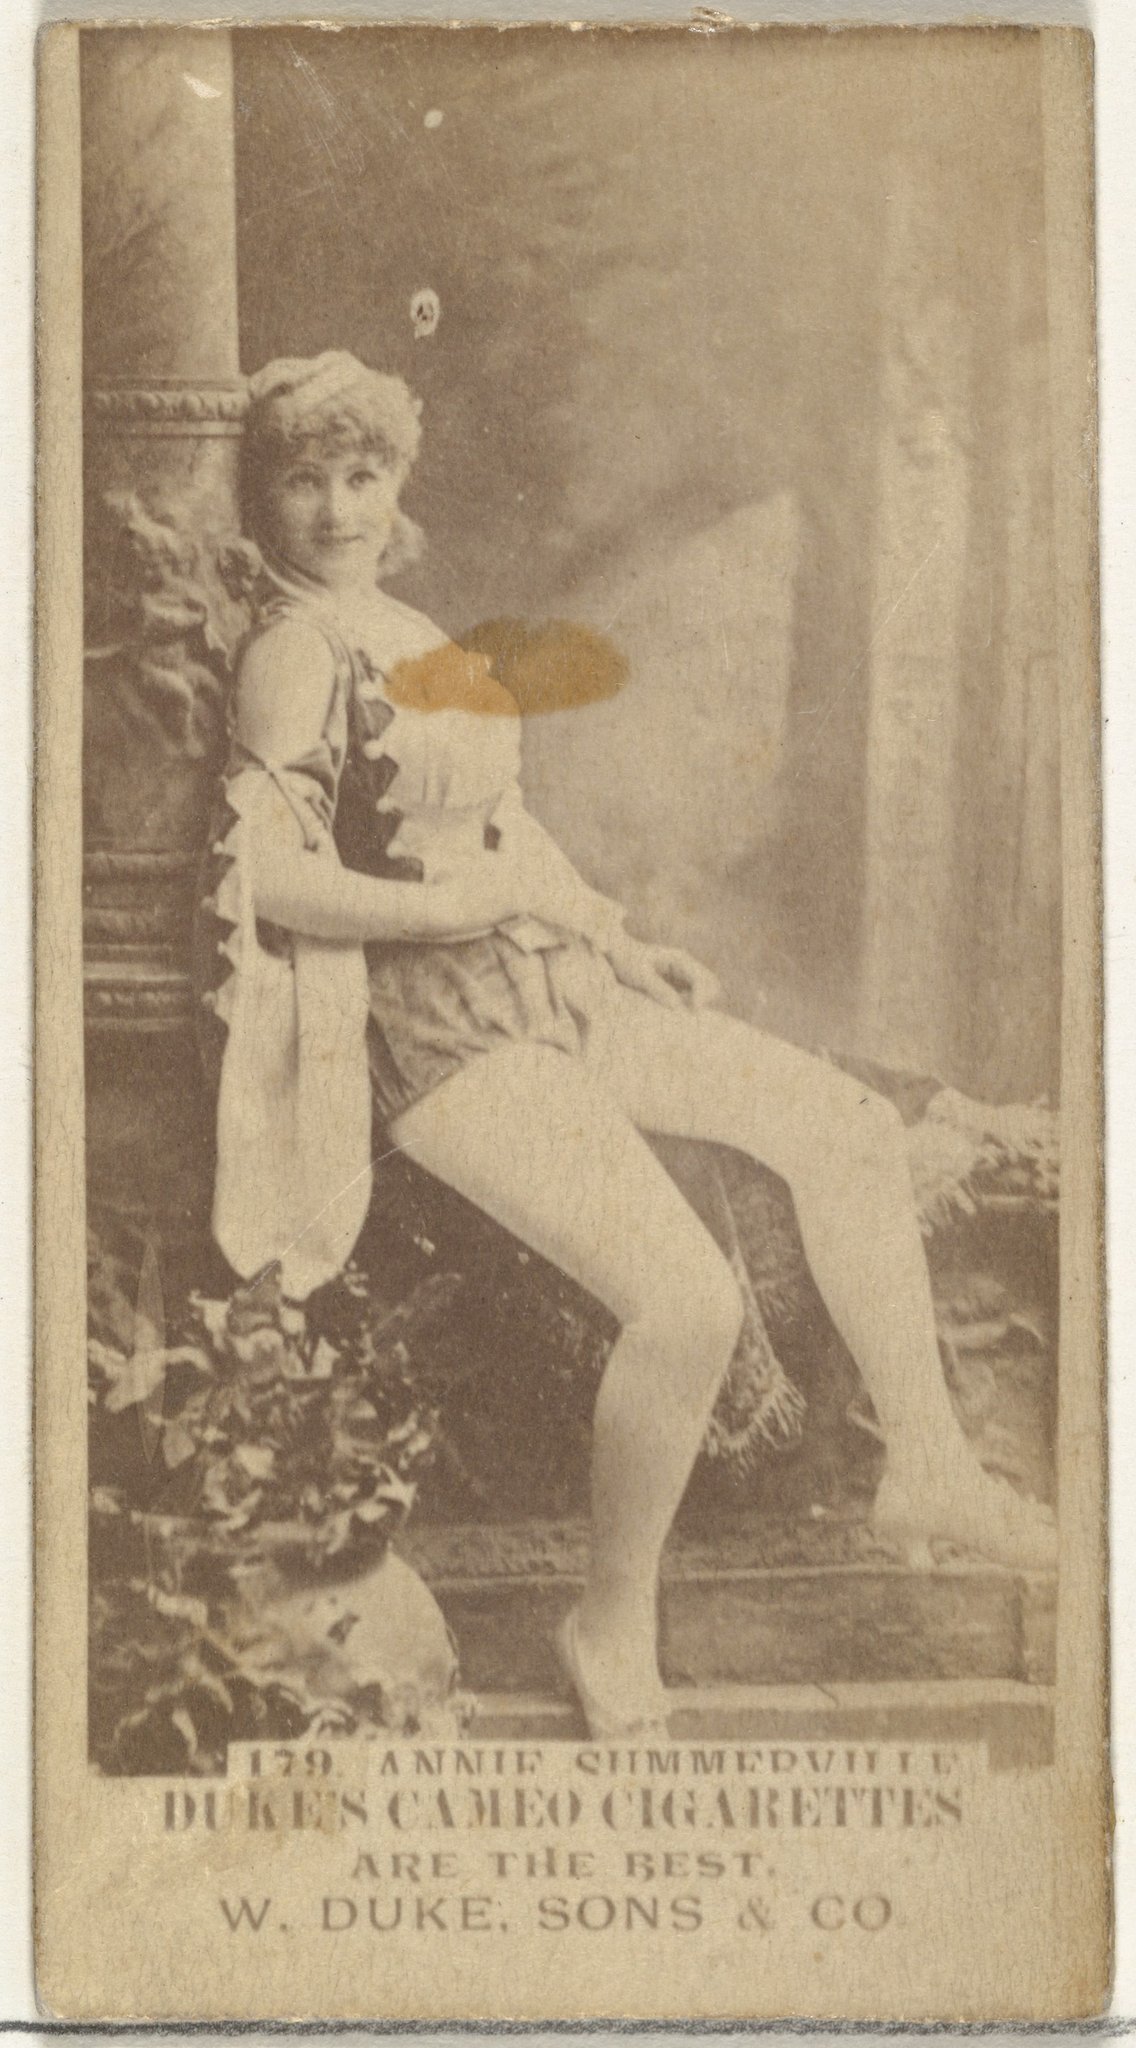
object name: photograph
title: Card Number 179, Annie Summerville, from the Actors and Actresses series (N145-5) issued by Duke Sons & Co. to promote Cameo Cigarettes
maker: w. duke, sons & co.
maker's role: publisher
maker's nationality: american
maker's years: 1870-1920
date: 1880-1889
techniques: albumen silver print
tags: portraits,women,actresses